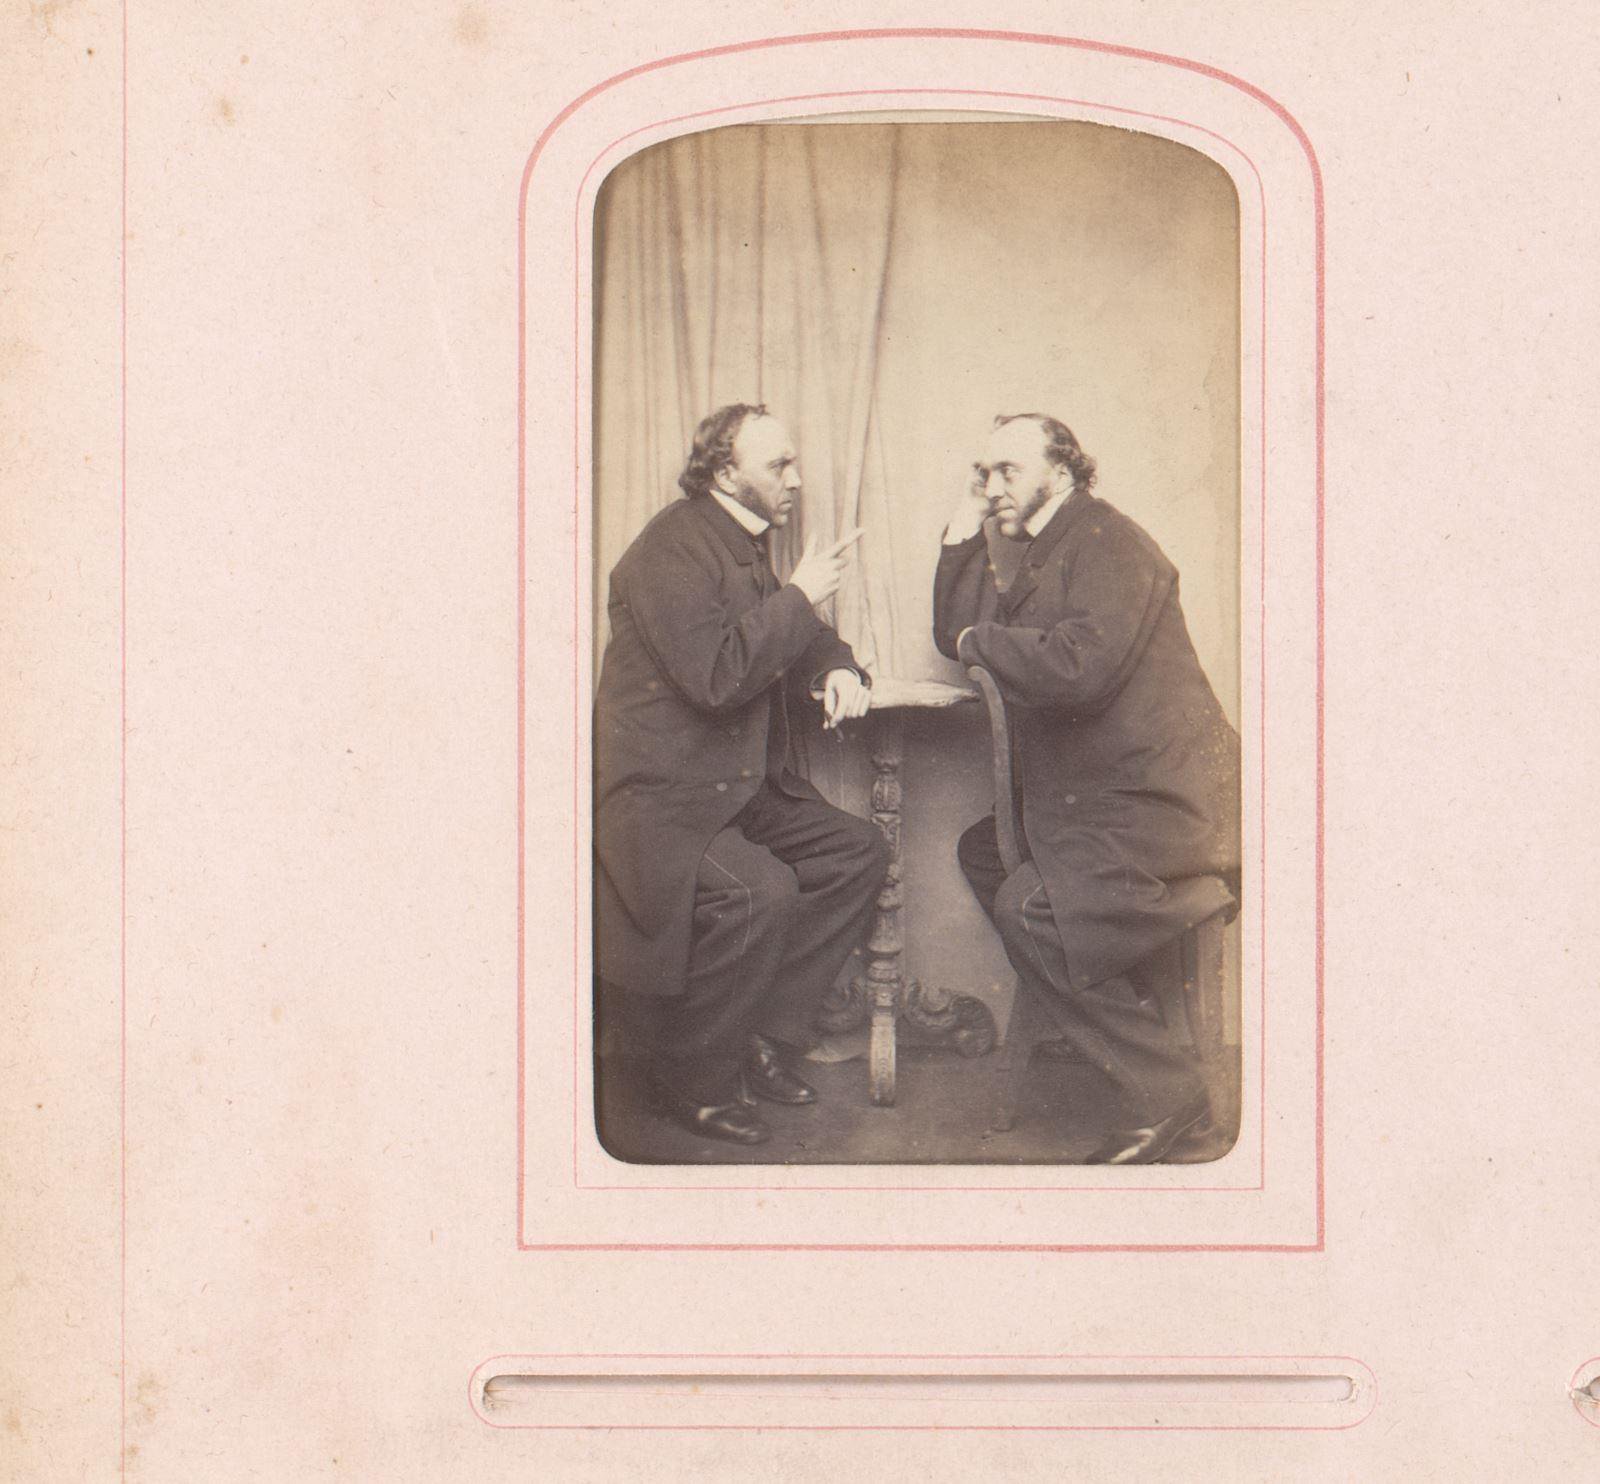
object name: carte de visite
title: Bastiaan de Greef in gesprek met zichzelf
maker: leonard de koningh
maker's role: draughtsman, painter, print maker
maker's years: 1810-1887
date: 1864-1879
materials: cardboard, paper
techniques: albumen print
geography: dordrecht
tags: amsterdam, bastiaan de greef, adult man, conversation, dialogue; conversation piece, dordrecht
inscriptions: inscription: ‘L. de Koningh/ Dordrecht.’